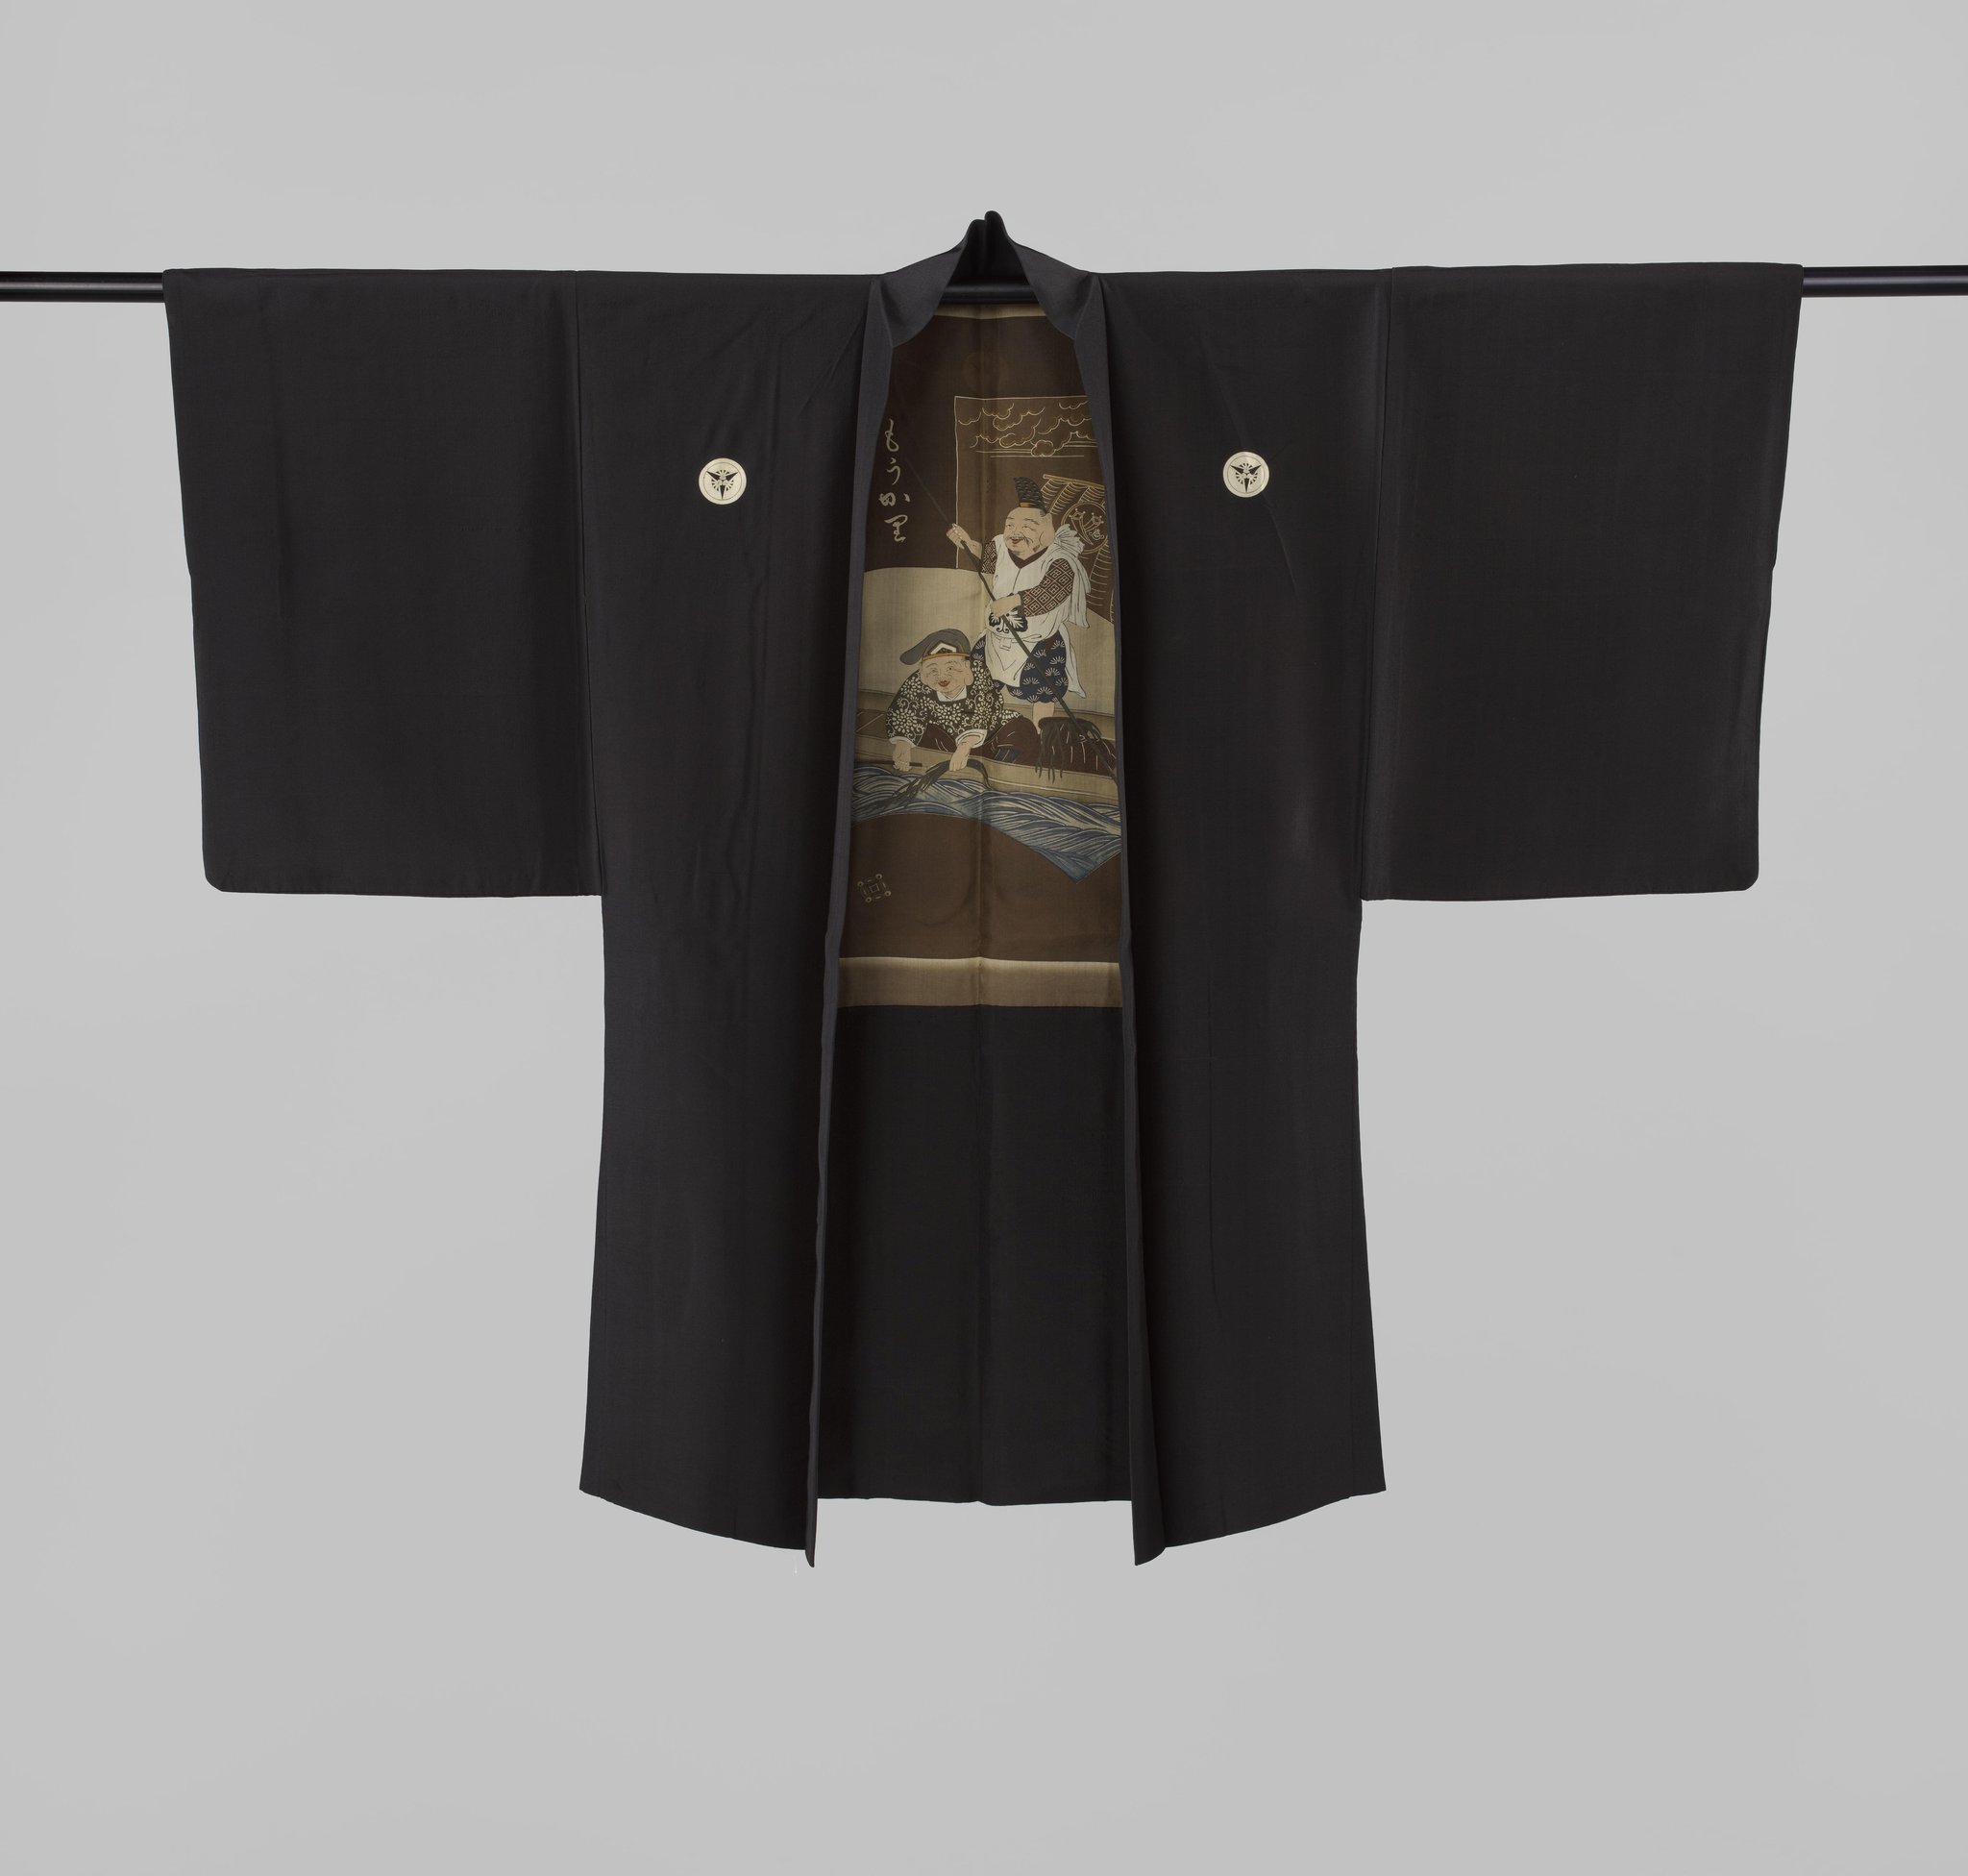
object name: kimono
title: Mannen haori met Ebisu en Daikoku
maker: Anonymous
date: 1920-1940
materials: silk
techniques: painting, weave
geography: japan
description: Haori voor een man met een versiering op de voering van de geluksgoden Ebisu en Daikoku, staand en zittend in een platbodem, terwijl ze zeewier aan het oogsten zijn, op de achtergrond een vierkant cartouche met een afbeelding in witte lijnen van hun voertuig, het Schatten Schip; afbeeldingen van kostbaarheden er verspreid omheen met de tekst ‘Akinai wa mo kari fune ya takarabune’ (‘De zaken gingen voorspoedig met het schip - een Schatten Ship’). Zwarte glanzende zijde (habutae) met decoratie in gestencilde yuzen. Vijf familiewapens (mon) van drie vouwwaaiers (ogi).